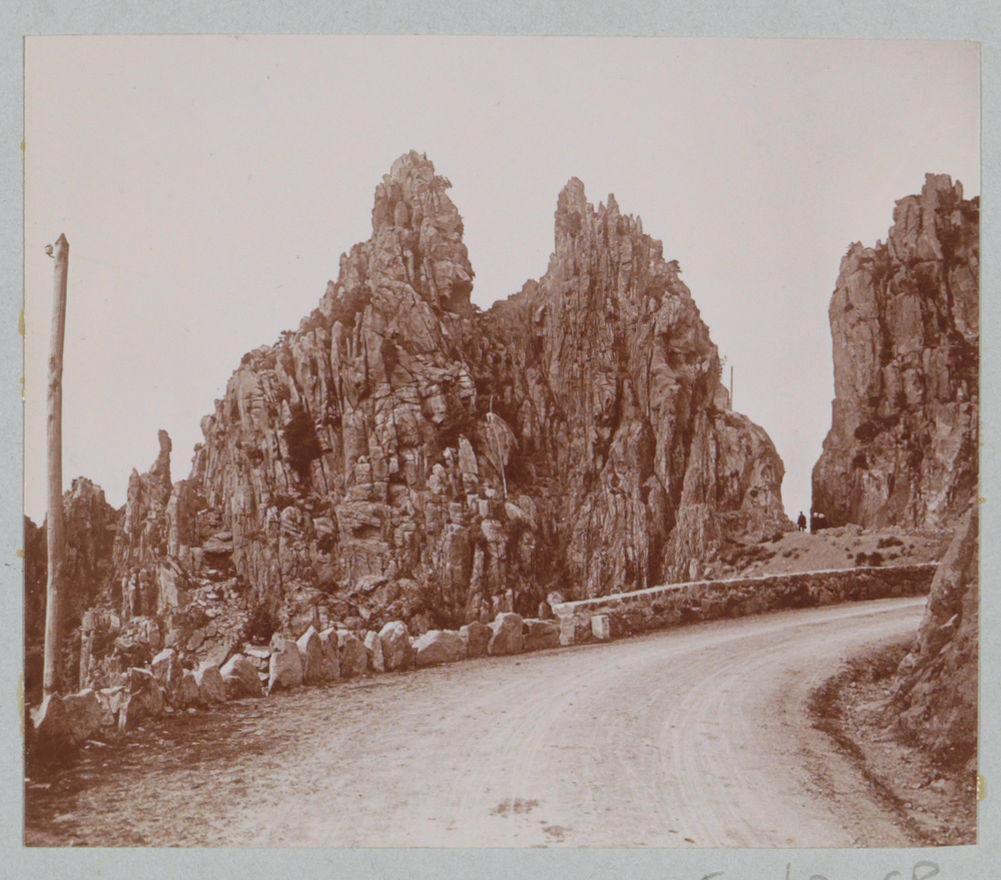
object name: photograph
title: Weg langs rotsformaties, vermoedelijk op Corsica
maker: Anonymous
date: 1905-1910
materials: paper, photographic support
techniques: gelatin silver print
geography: corsica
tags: rock-formations, public road, mountains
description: Onderdeel van Fotoalbum van een Franse amateurfotograaf met bezienswaardigheden in Frankrijk, Zwitserland en Italië.